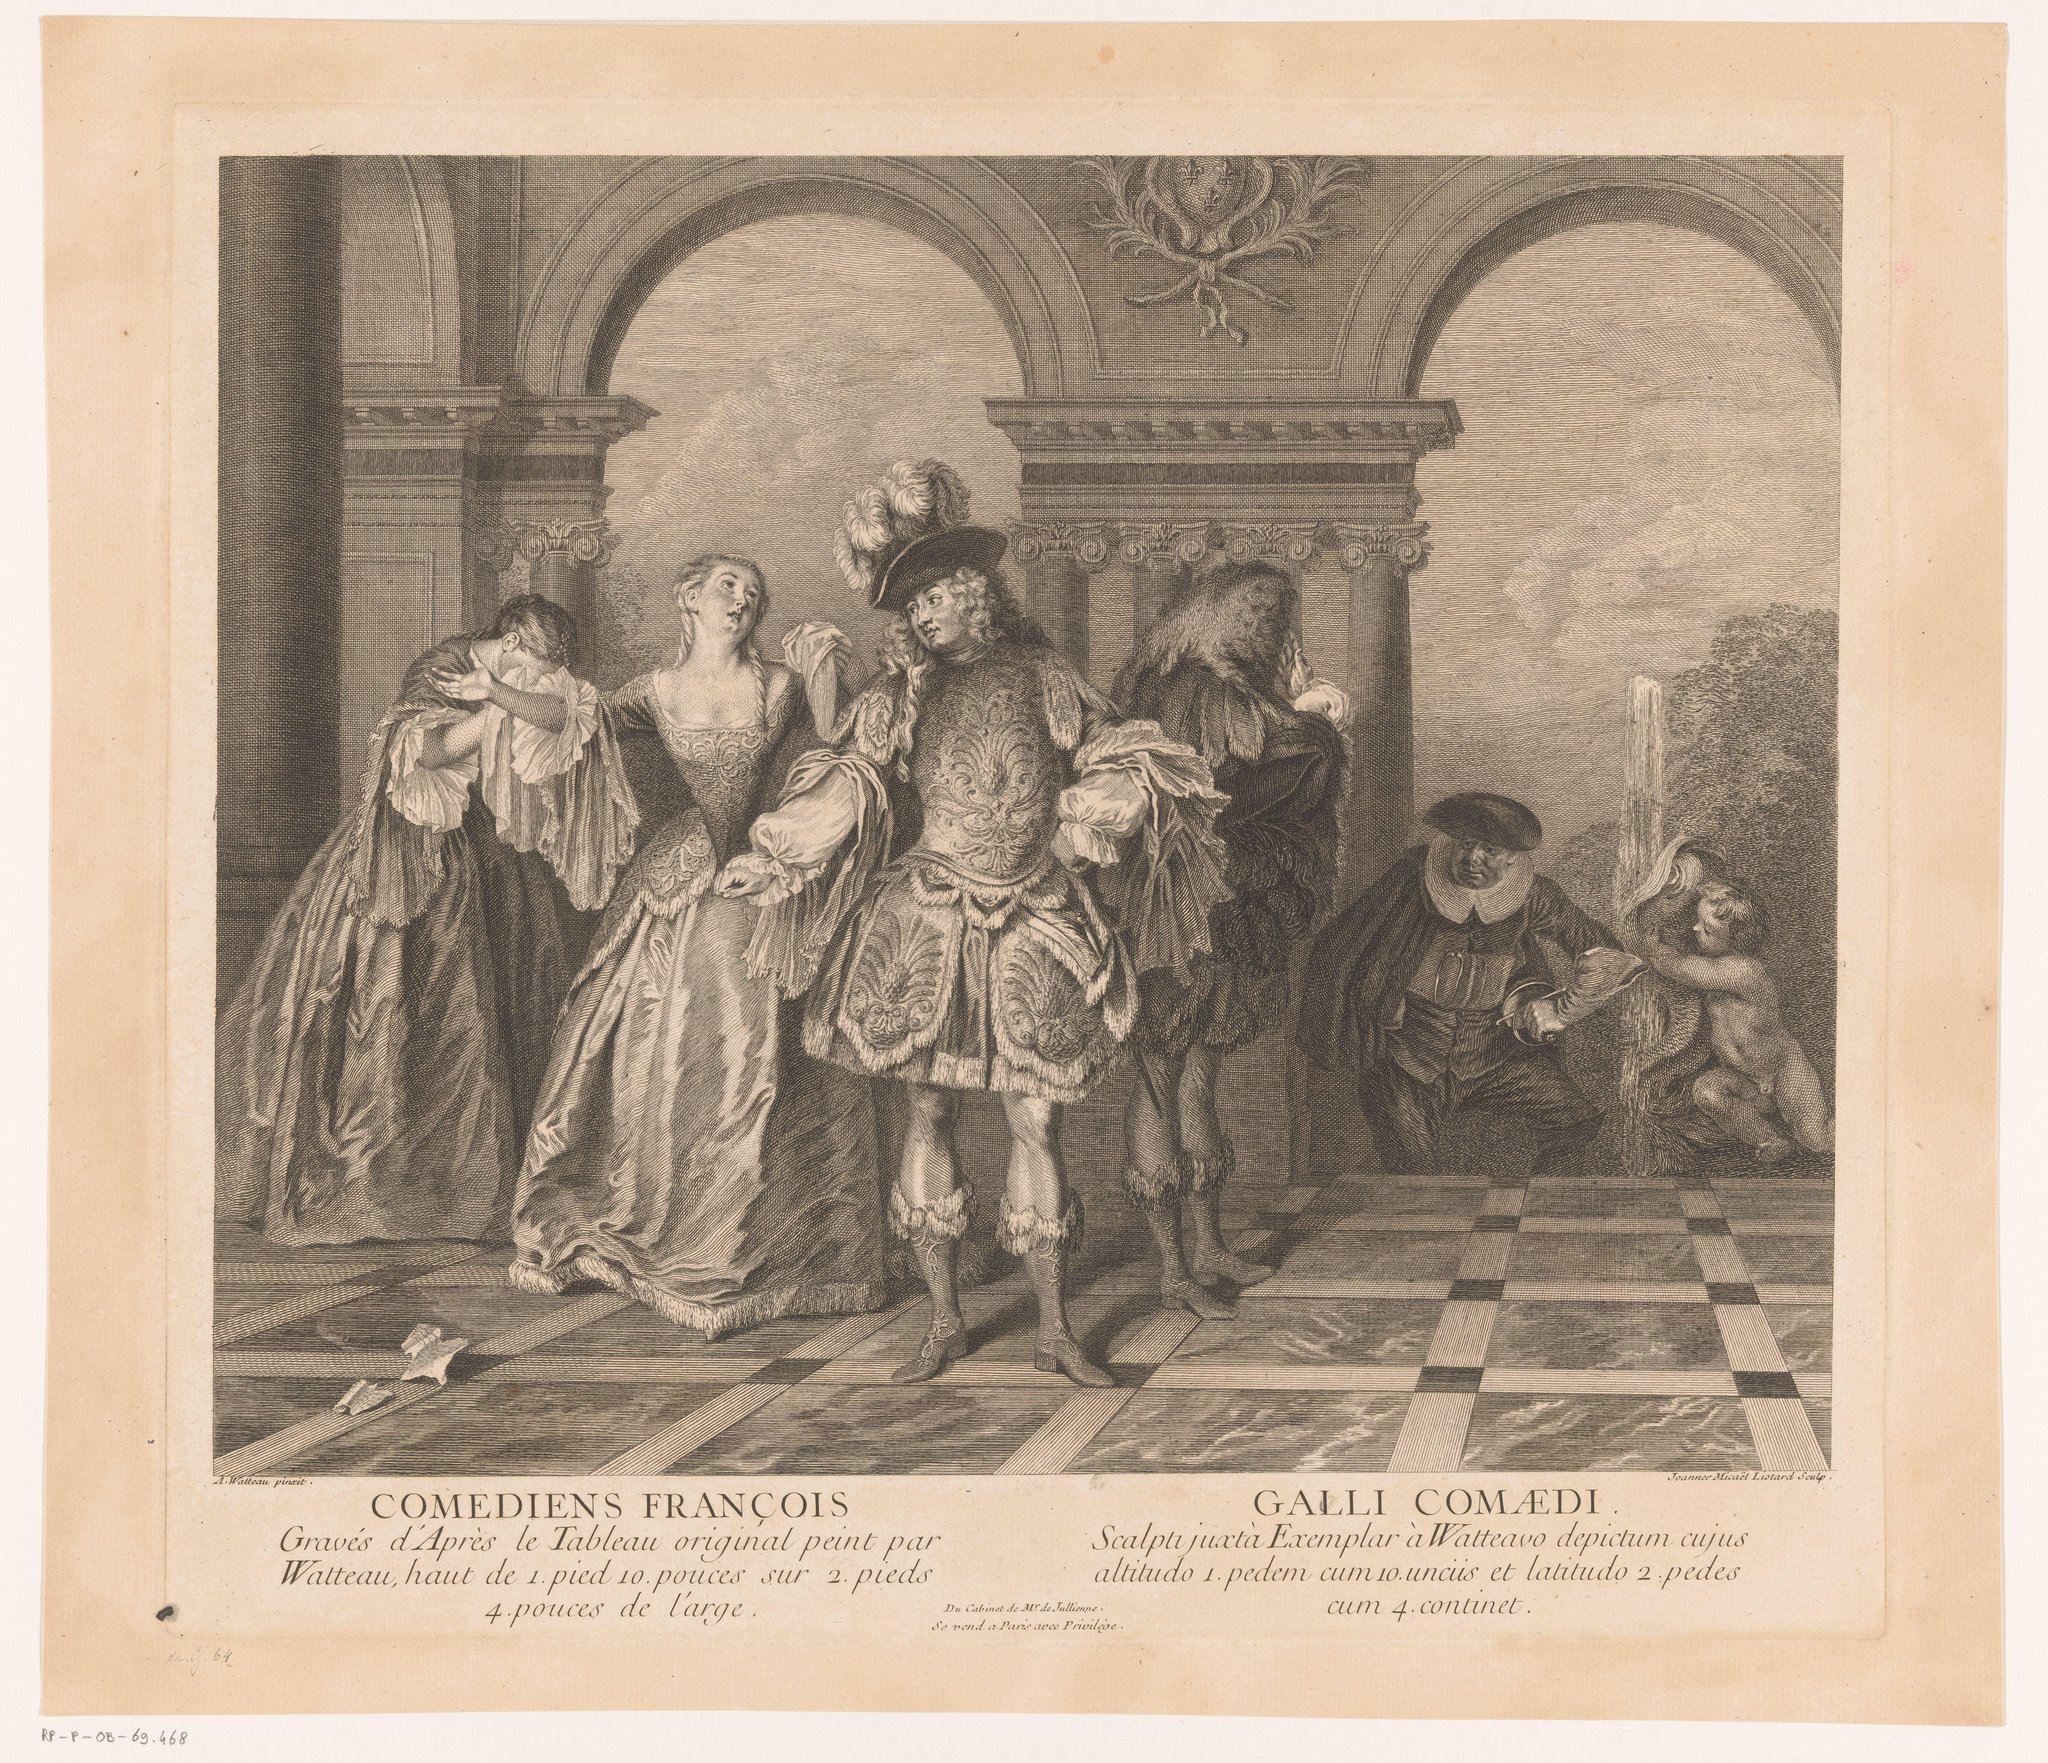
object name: print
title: Groep acteurs op een podium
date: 1726-1735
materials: paper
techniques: etching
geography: paris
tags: group of actors, troupe; actors on the stage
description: Maakt deel uit van een serie van 271 platen naar schilderijen door Watteau, verdeeld over drie delen, gecoördineerd door Jean de Jullienne en uitgegeven in Parijs tussen 1726 en 1735. Sommige platen werden reeds tijdens Watteau's leven gemaakt.